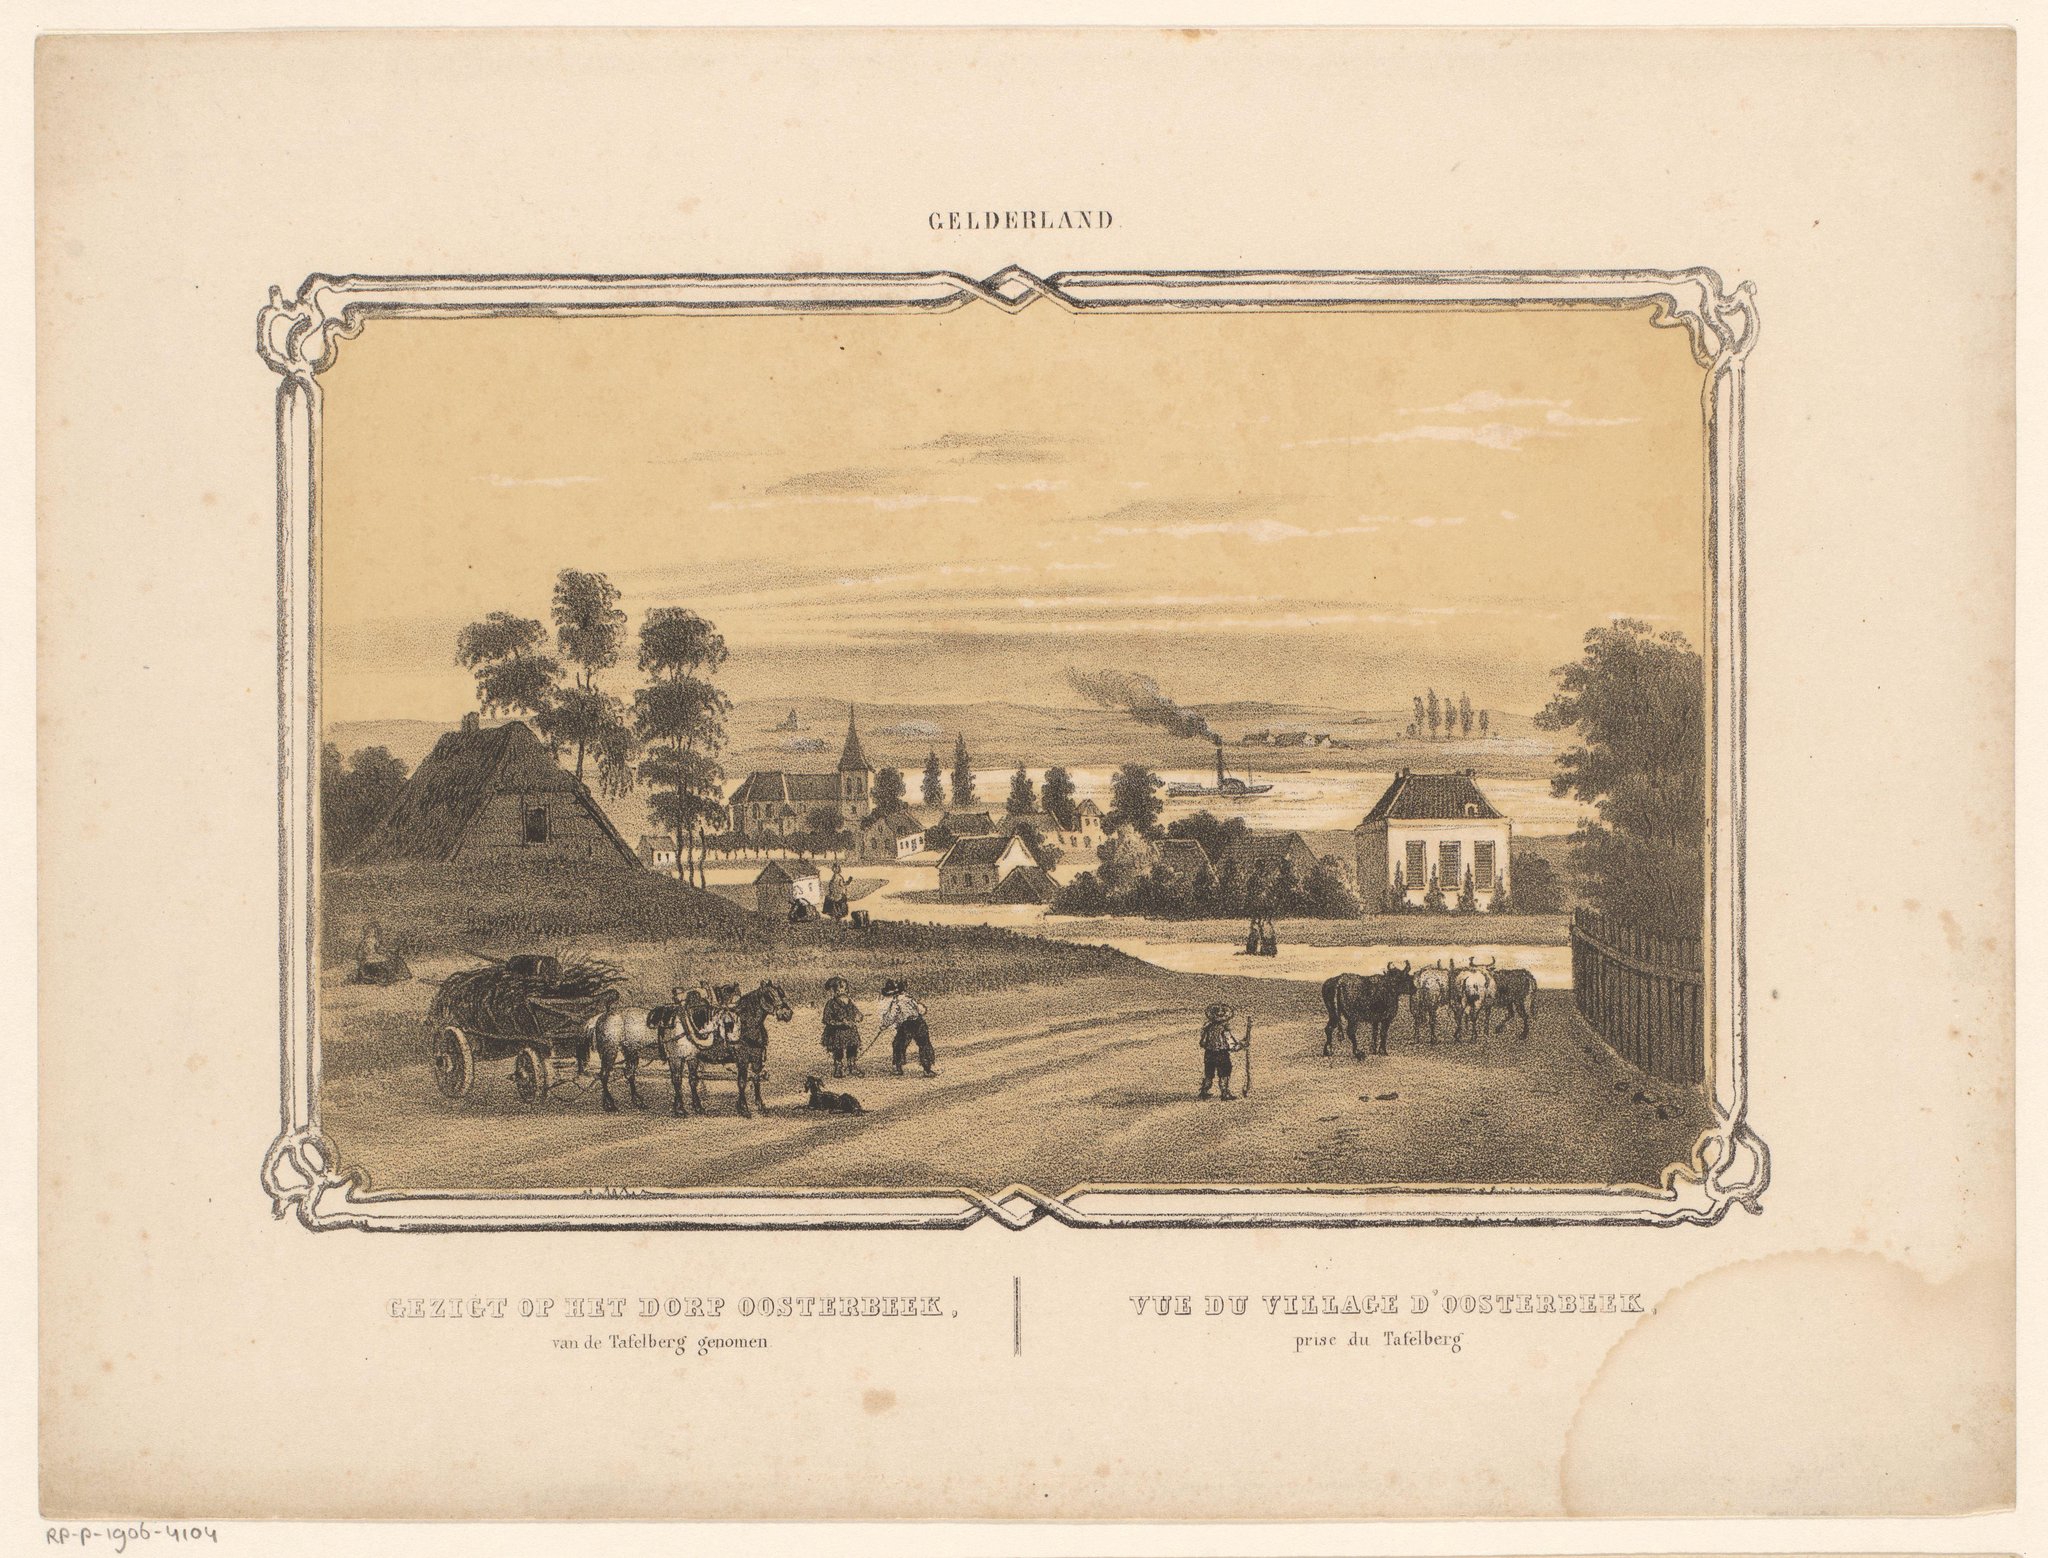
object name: print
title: Gelderland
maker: frederik lodewijk huygens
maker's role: draughtsman, print maker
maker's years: 1802-1887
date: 1812-1887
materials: paper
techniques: tone lithography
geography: netherlands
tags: hut, cabin, lodge, city-view, and landscape with man-made constructions (+ city(-scape) with figures, staffage), paddle-wheel boat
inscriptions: collector's mark: Lugt 2228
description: Maakt deel uit van een serie over Gelderland, zie RP-P-1906-4096 t/m 4099 en RP-P-1906-4101 t/m 4109.